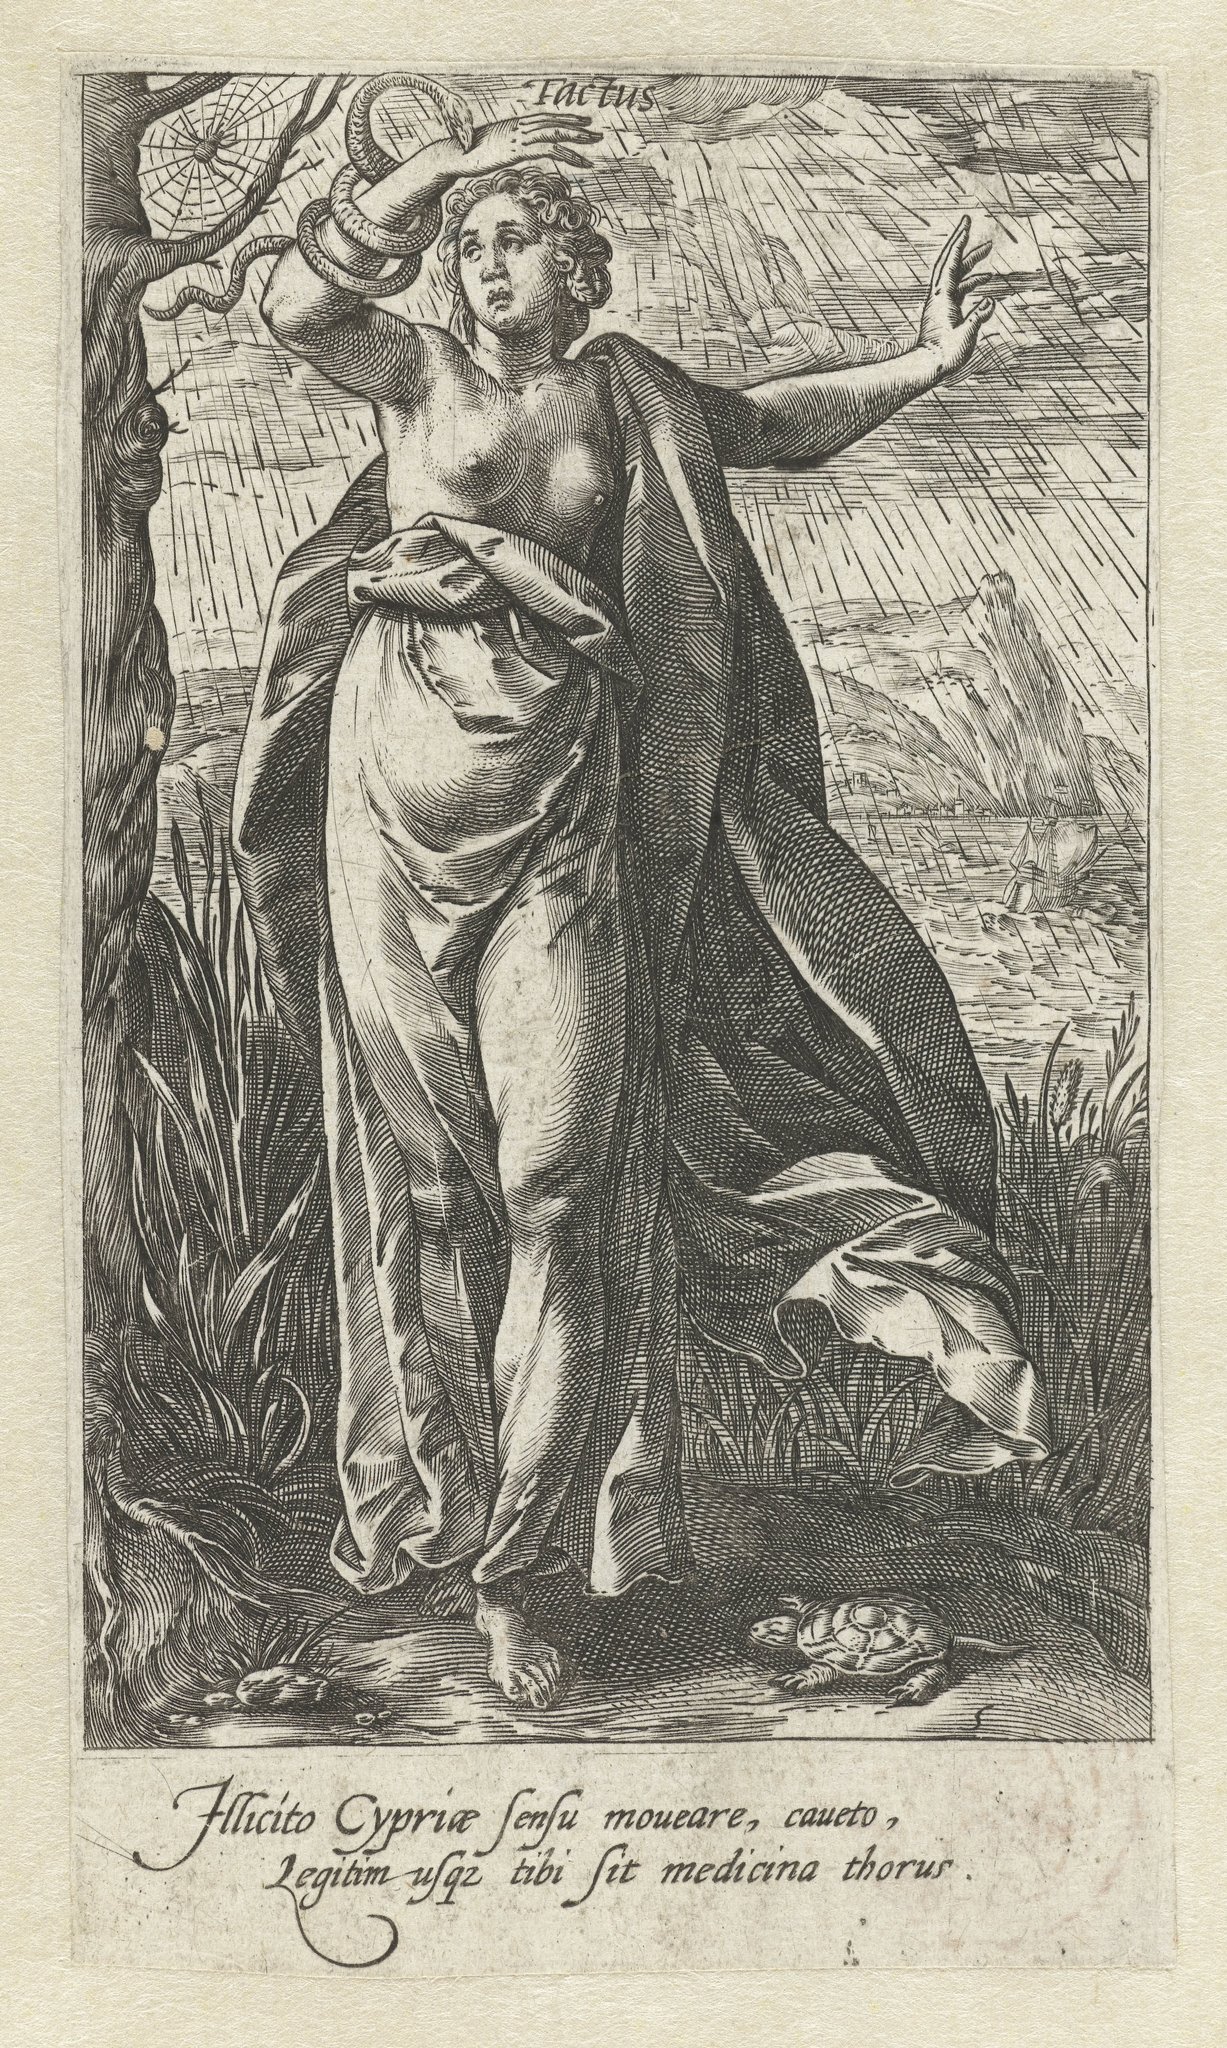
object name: print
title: Tactus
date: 1576-1580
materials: paper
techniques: engraving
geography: haarlem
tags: feeling (one of the five senses)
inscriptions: collector's mark: Lugt 240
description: Prent uit een serie van vijf. Op elk blad is een personificatie te zien van een van de vijf zintuigen. Onder elke prent uit deze serie twee regels Latijn.